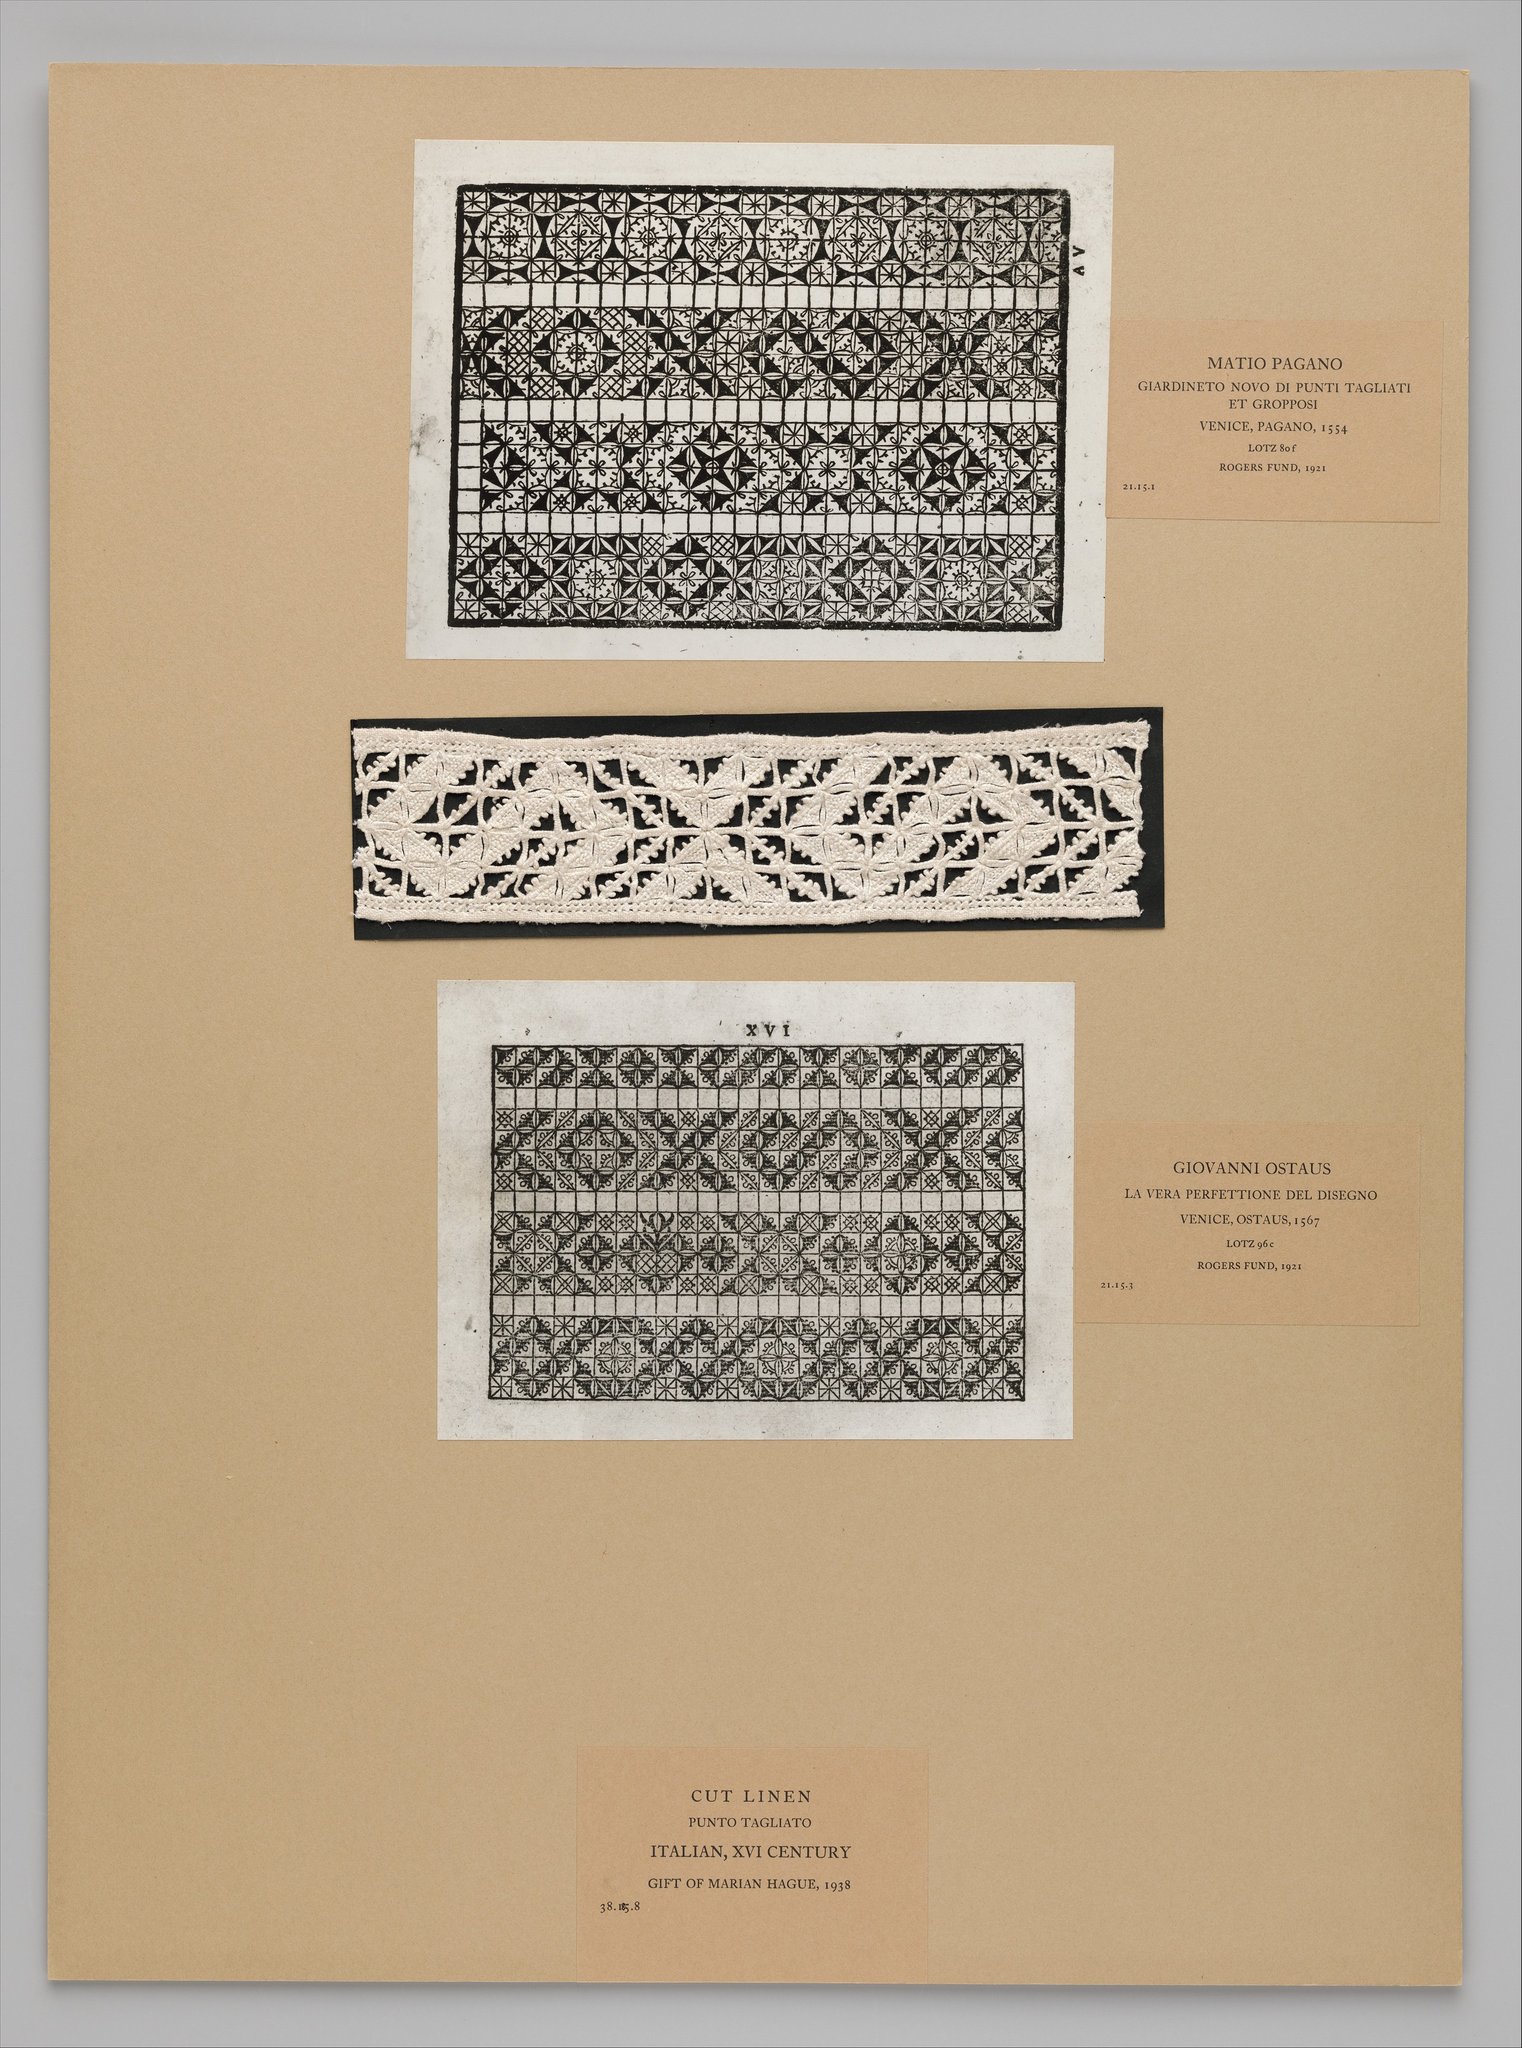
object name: insertion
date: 1501-1600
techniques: embroidery